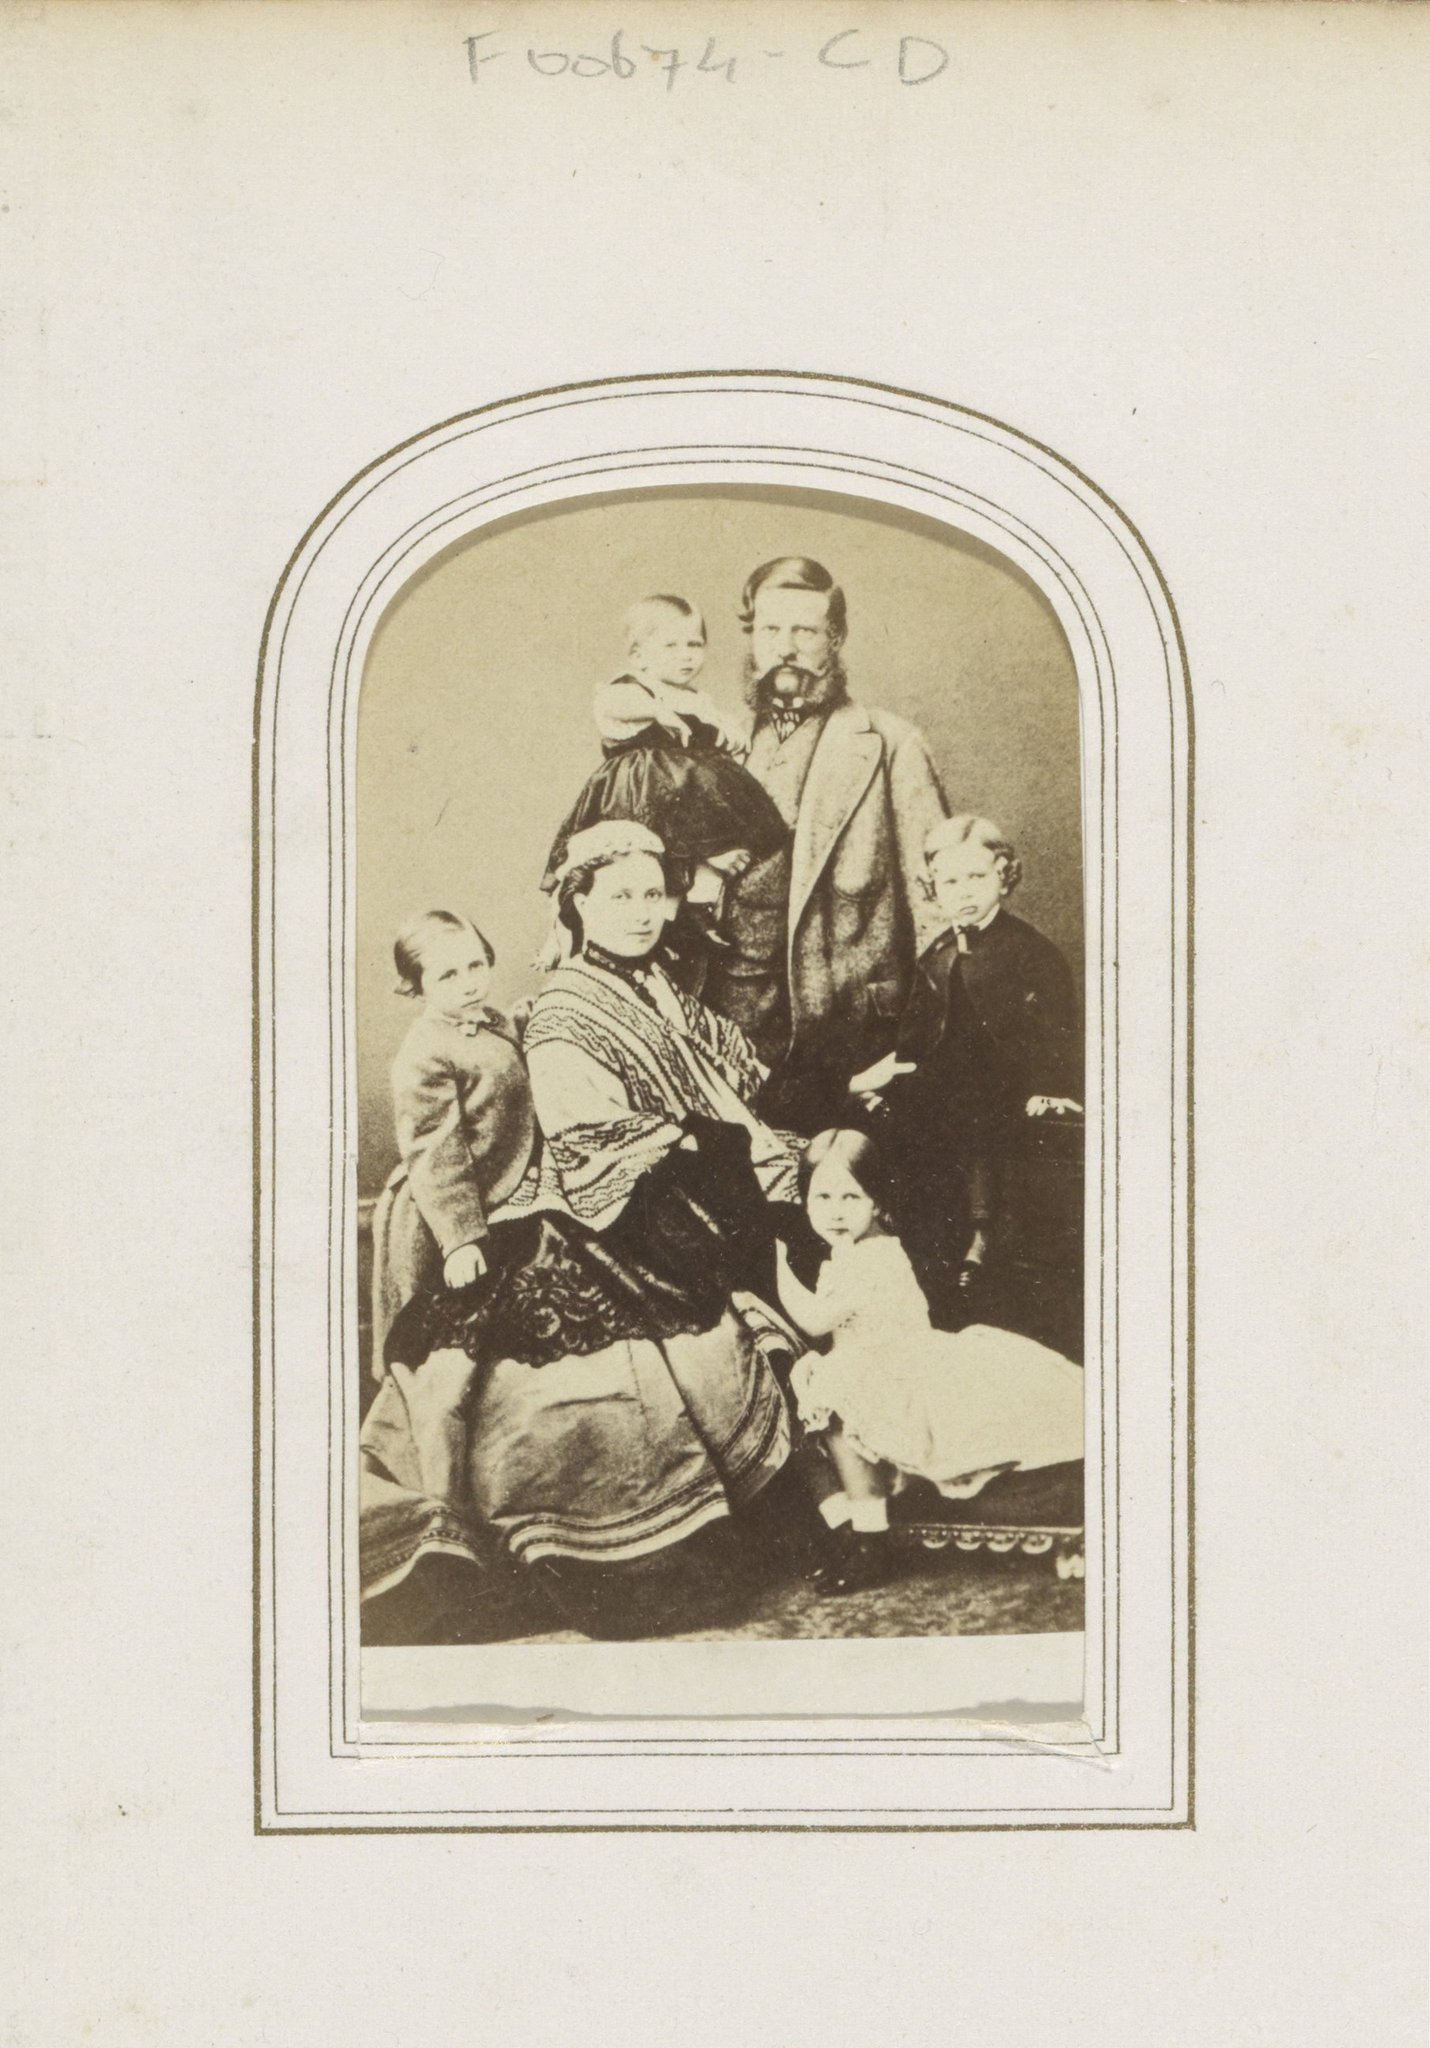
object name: carte de visite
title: Groepsportret van het gezin van Friedrich Wilhelm, kroonprins van Pruisen, met links Wilhelm (de latere keizer Wilhelm II)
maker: Anonymous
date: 1864-1867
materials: cardboard, paper, photographic support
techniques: albumen print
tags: wilhelm ii (keizer van duitsland), clothes, costume (+ children's clothes), family group, especially parents with their child(ren), prince, historical persons, clothes, costume (+ women's clothes), clothes, costume (+ men's clothes), ruler, sovereign, crown prince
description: Onderdeel van Fotoalbum met 123 cartes-de-visite van leden van Europese vorstenhuizen, politici en bekende personen.